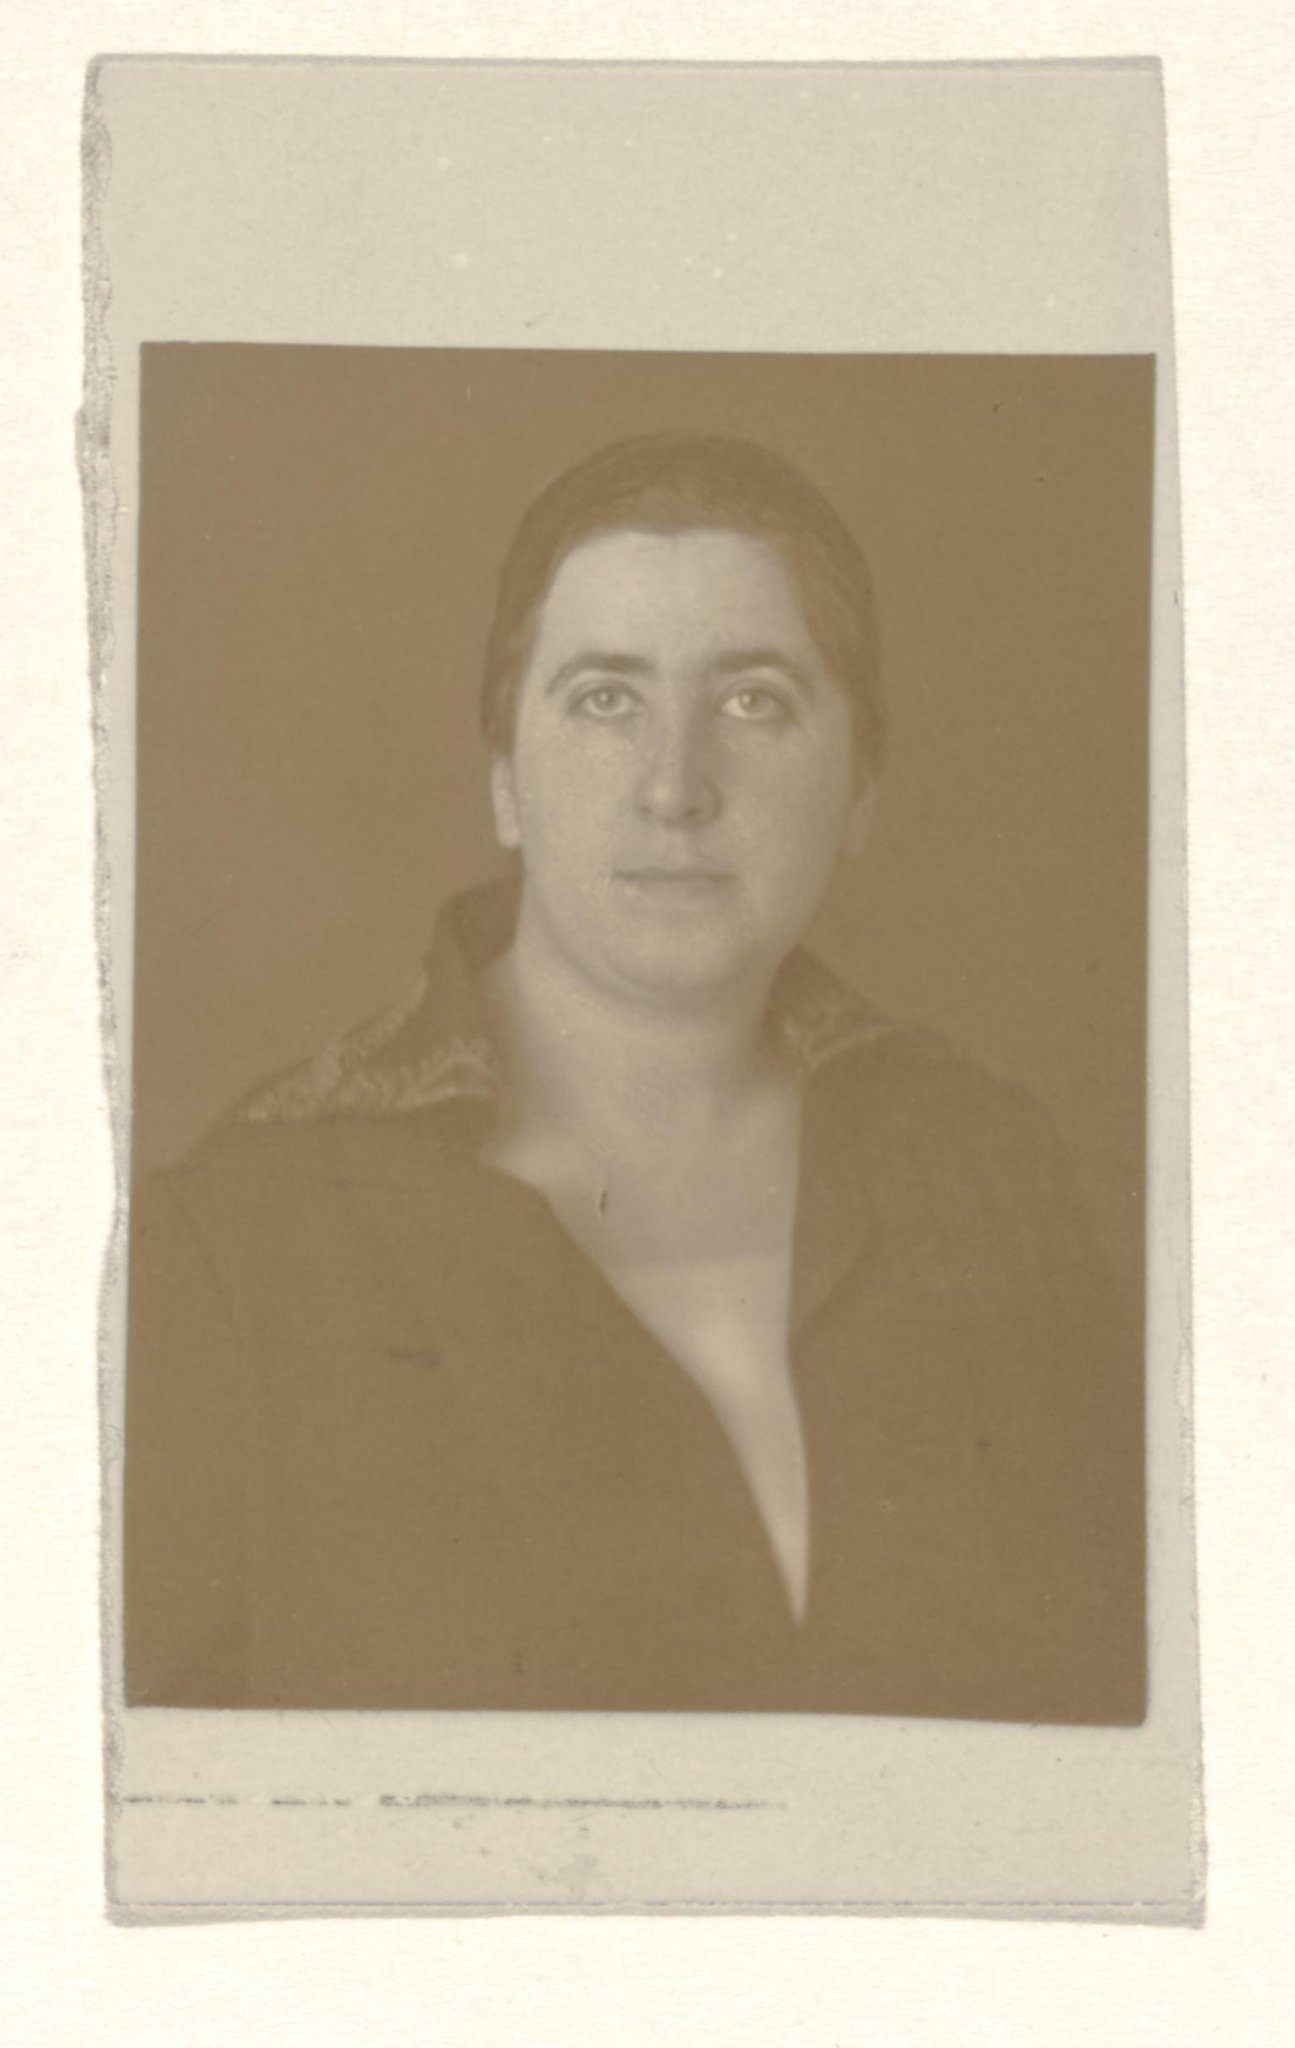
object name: photograph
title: Else Wachenheimer-Moos met donkere kleding en bewerkte kraag, 1915-1943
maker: Anonymous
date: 1915-1943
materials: photographic support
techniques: gelatin silver print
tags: else wachenheimer-moos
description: Else Wachenheimer-Moos met donkere kleding en bewerkte kraag.